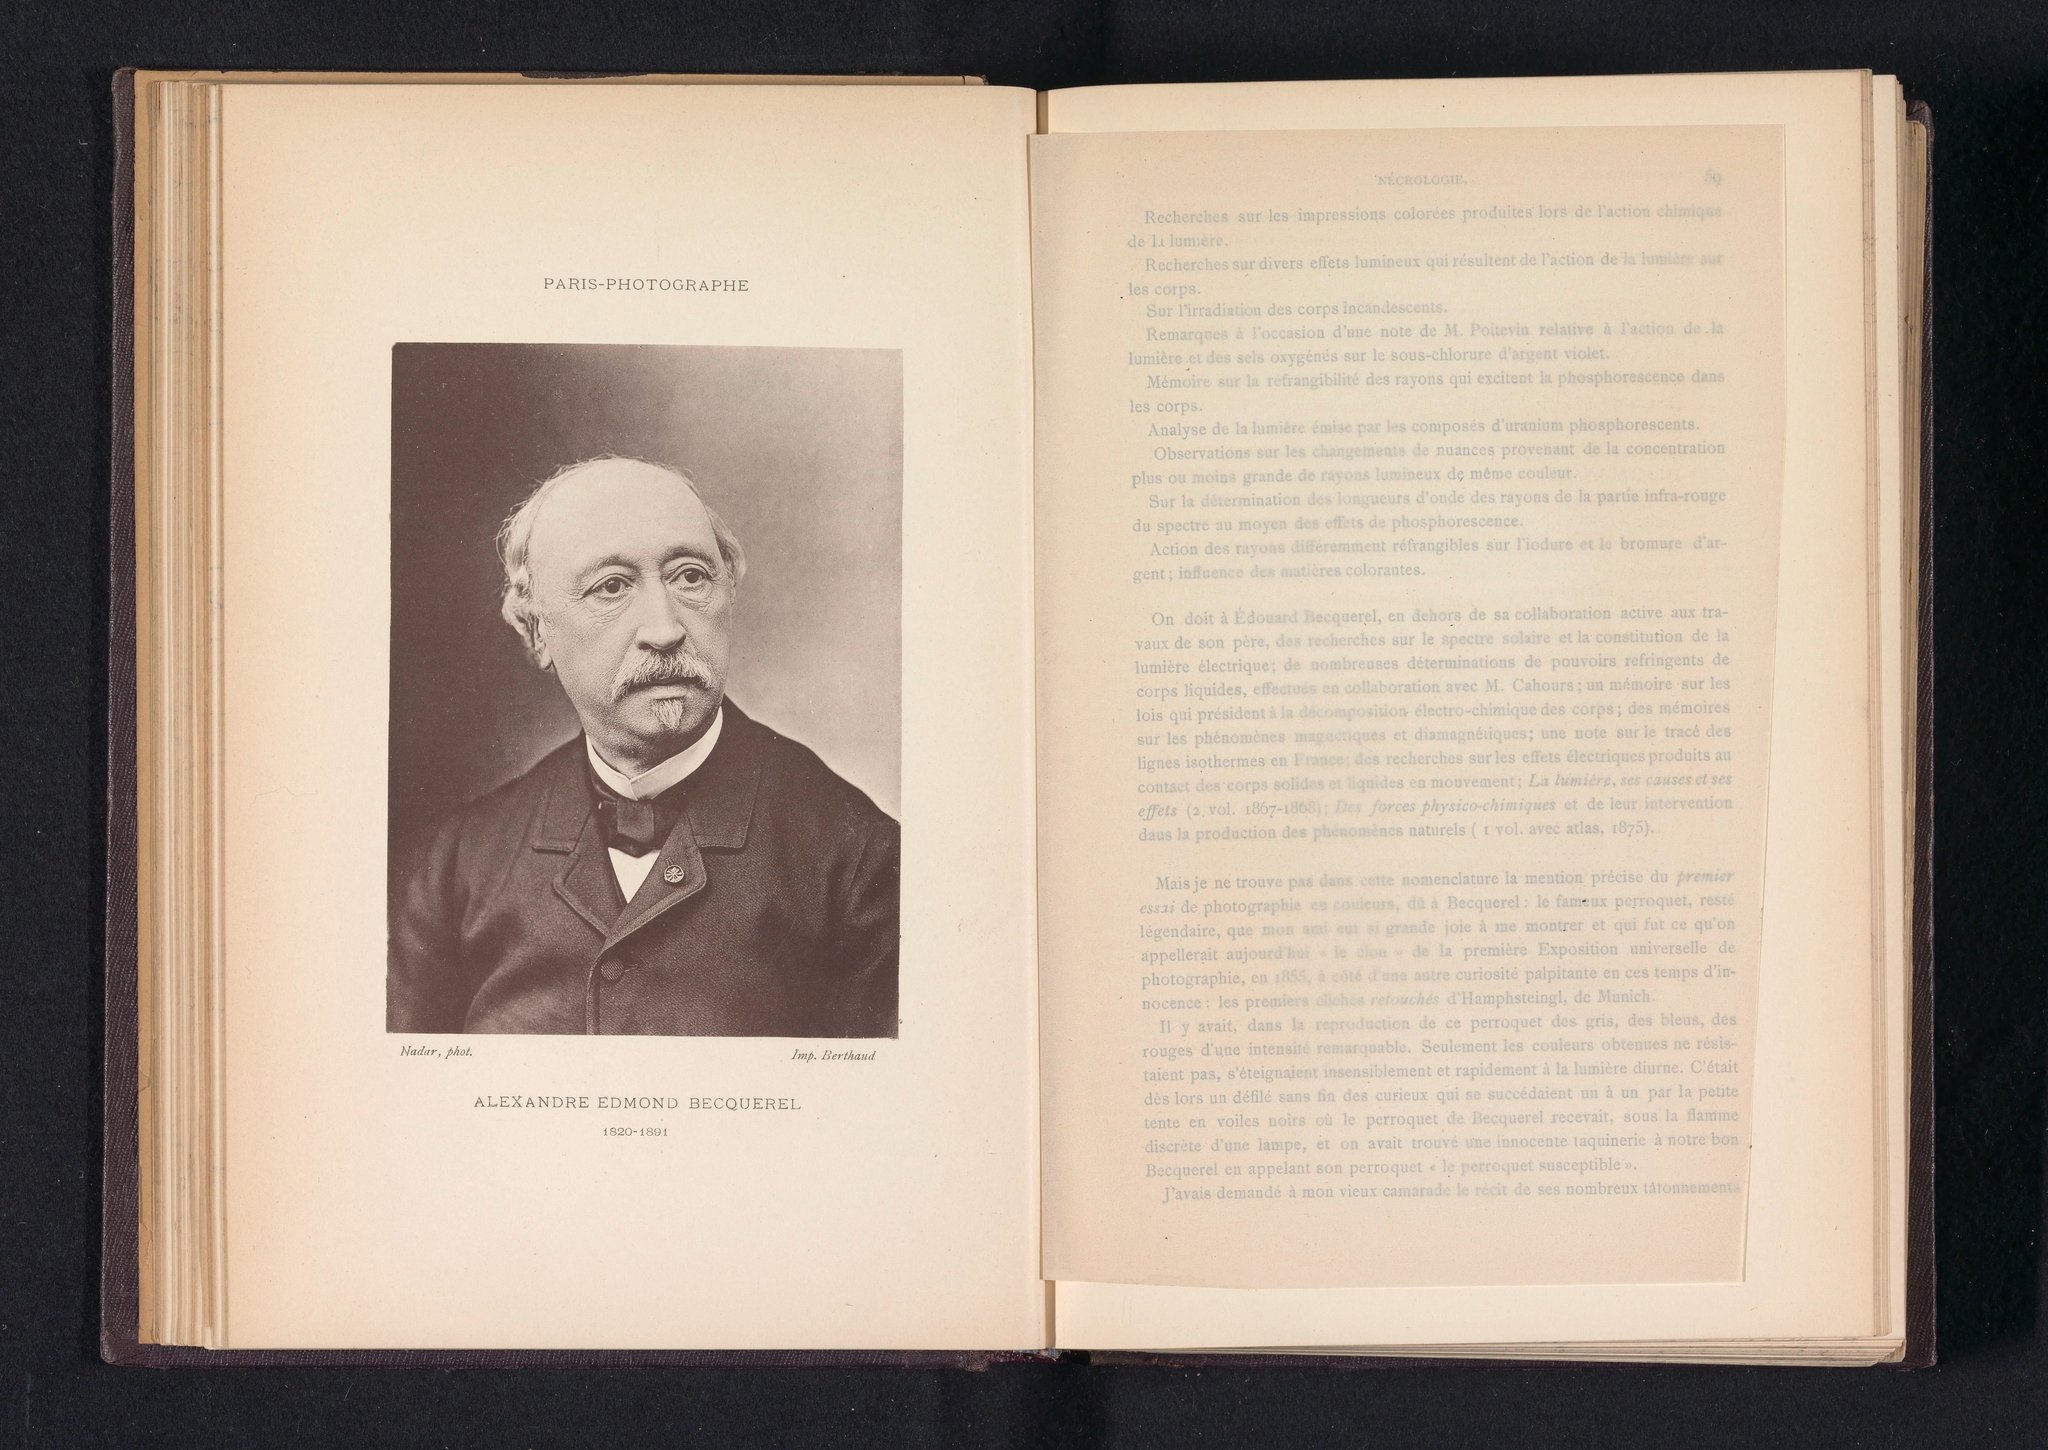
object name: page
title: Alexandre-Edmond Becquerel 1820-1891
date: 1881-1891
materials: paper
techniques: photograph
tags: adult man